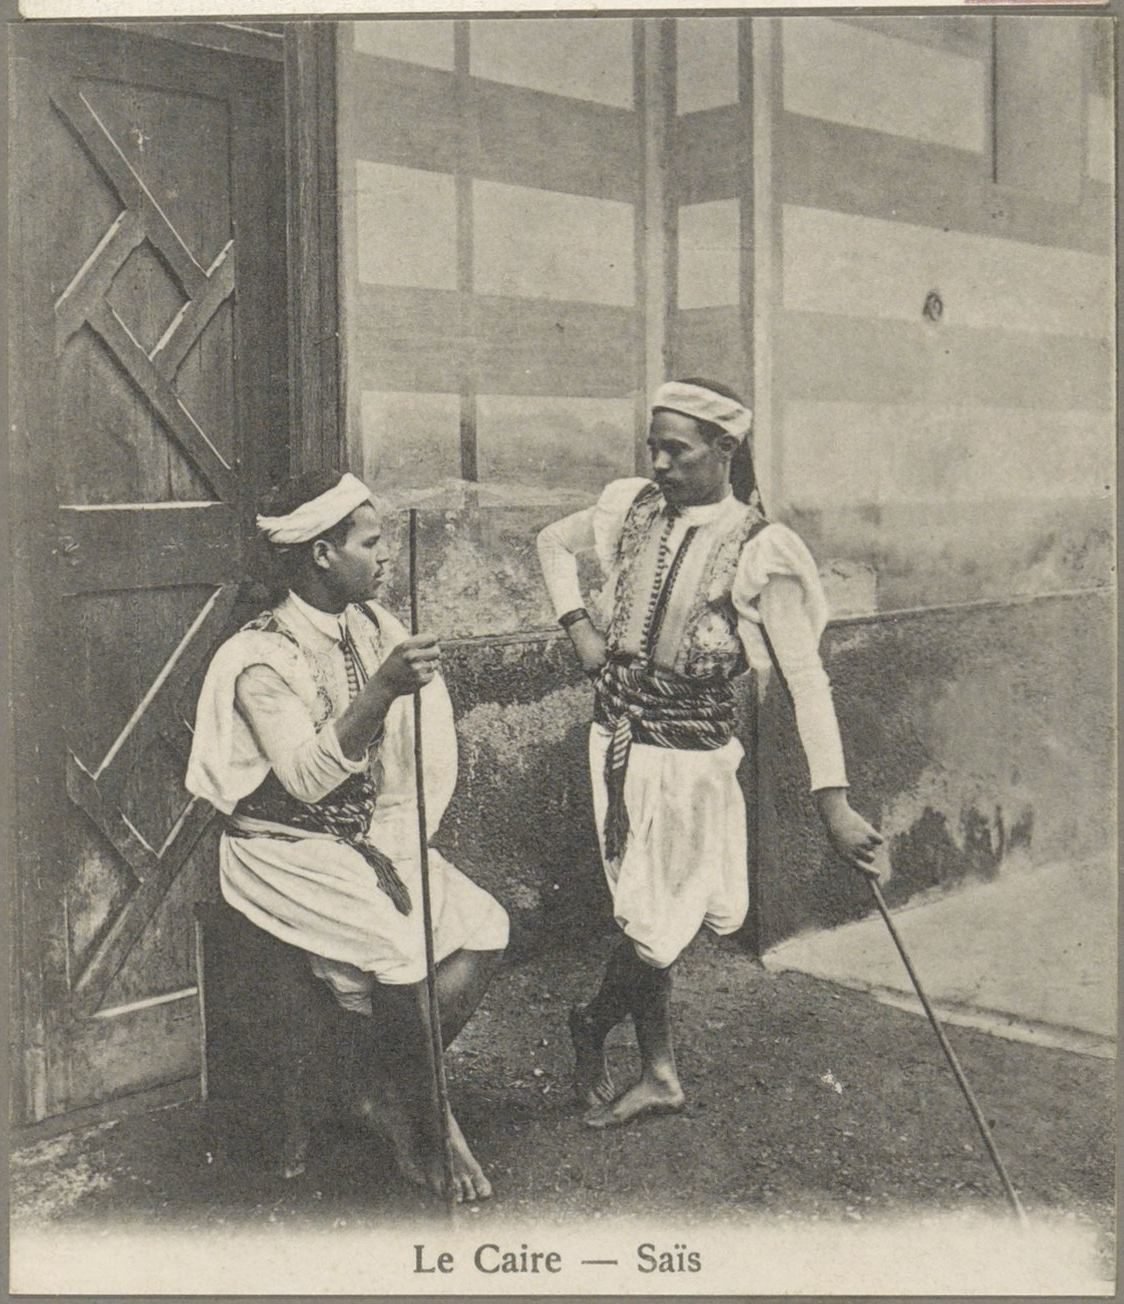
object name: ansichtkaart, prentbriefkaart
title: Mannen aangeduid als 'Saïs' op straat in Caïro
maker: Anonymous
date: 1895-1905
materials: paper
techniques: photograph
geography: cairo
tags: walking-stick, staff, adult man, folk costume, regional costume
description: Onderdeel van Reisalbum met foto's van bezienswaardigheden in Griekenland en Egypte.